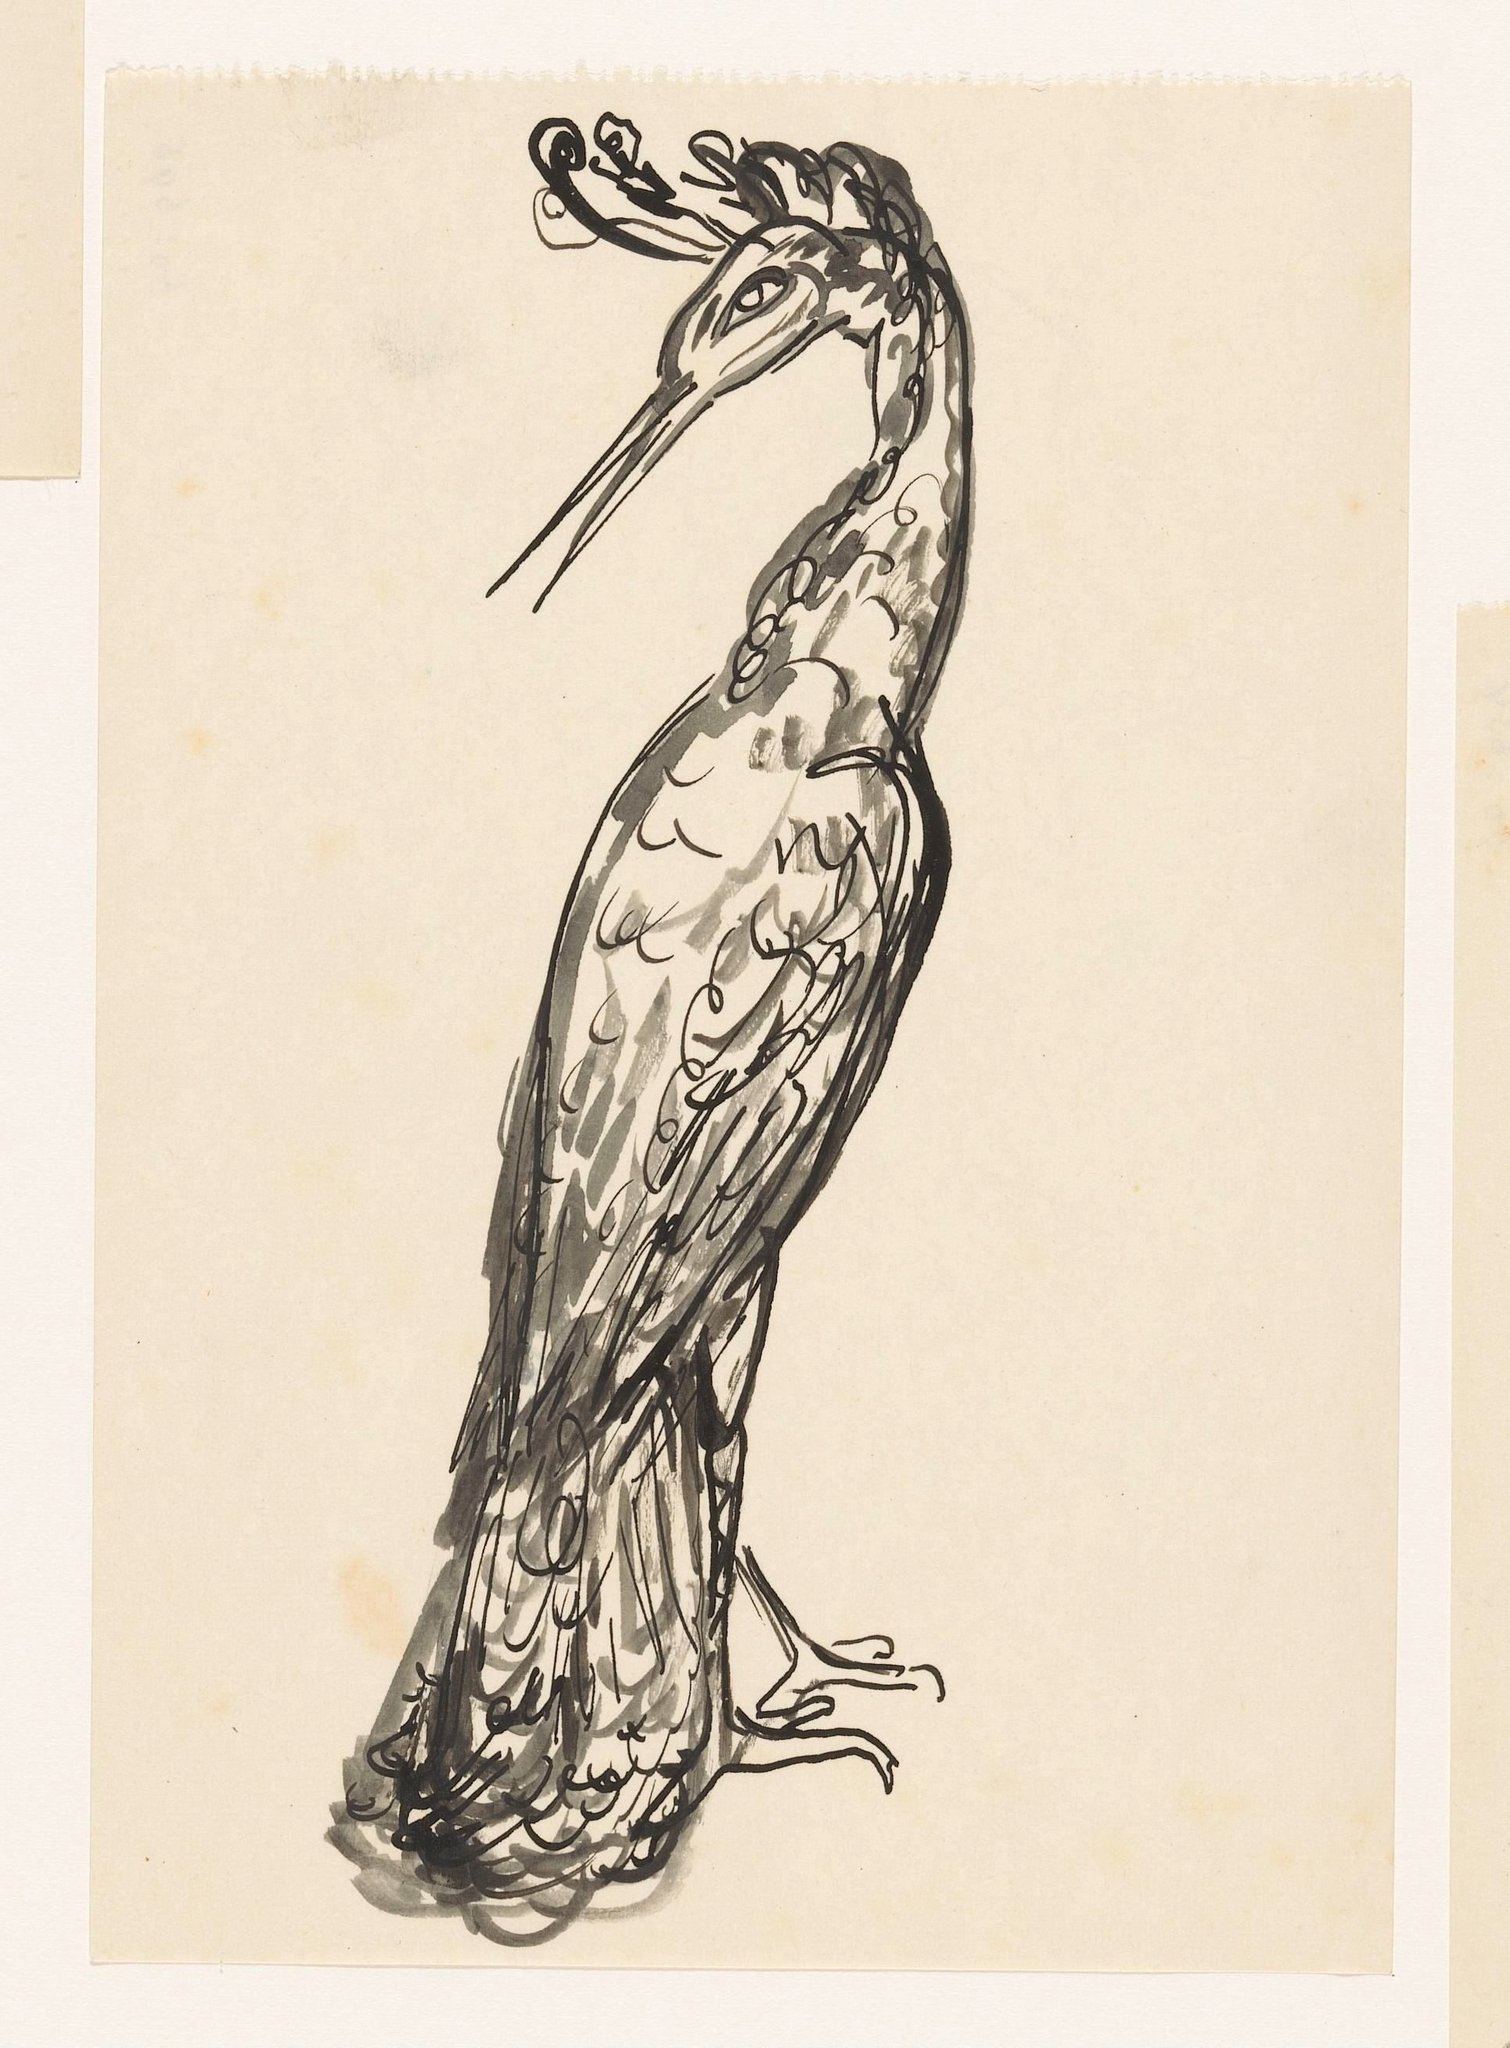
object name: drawing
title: Reiger met zijn kop naar achter gedraaid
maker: leo gestel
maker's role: draughtsman, print maker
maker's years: 1881-1941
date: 1891-1941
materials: paper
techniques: brush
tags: shore-birds and wading-birds: heron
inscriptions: collector's mark: Lugt 2228